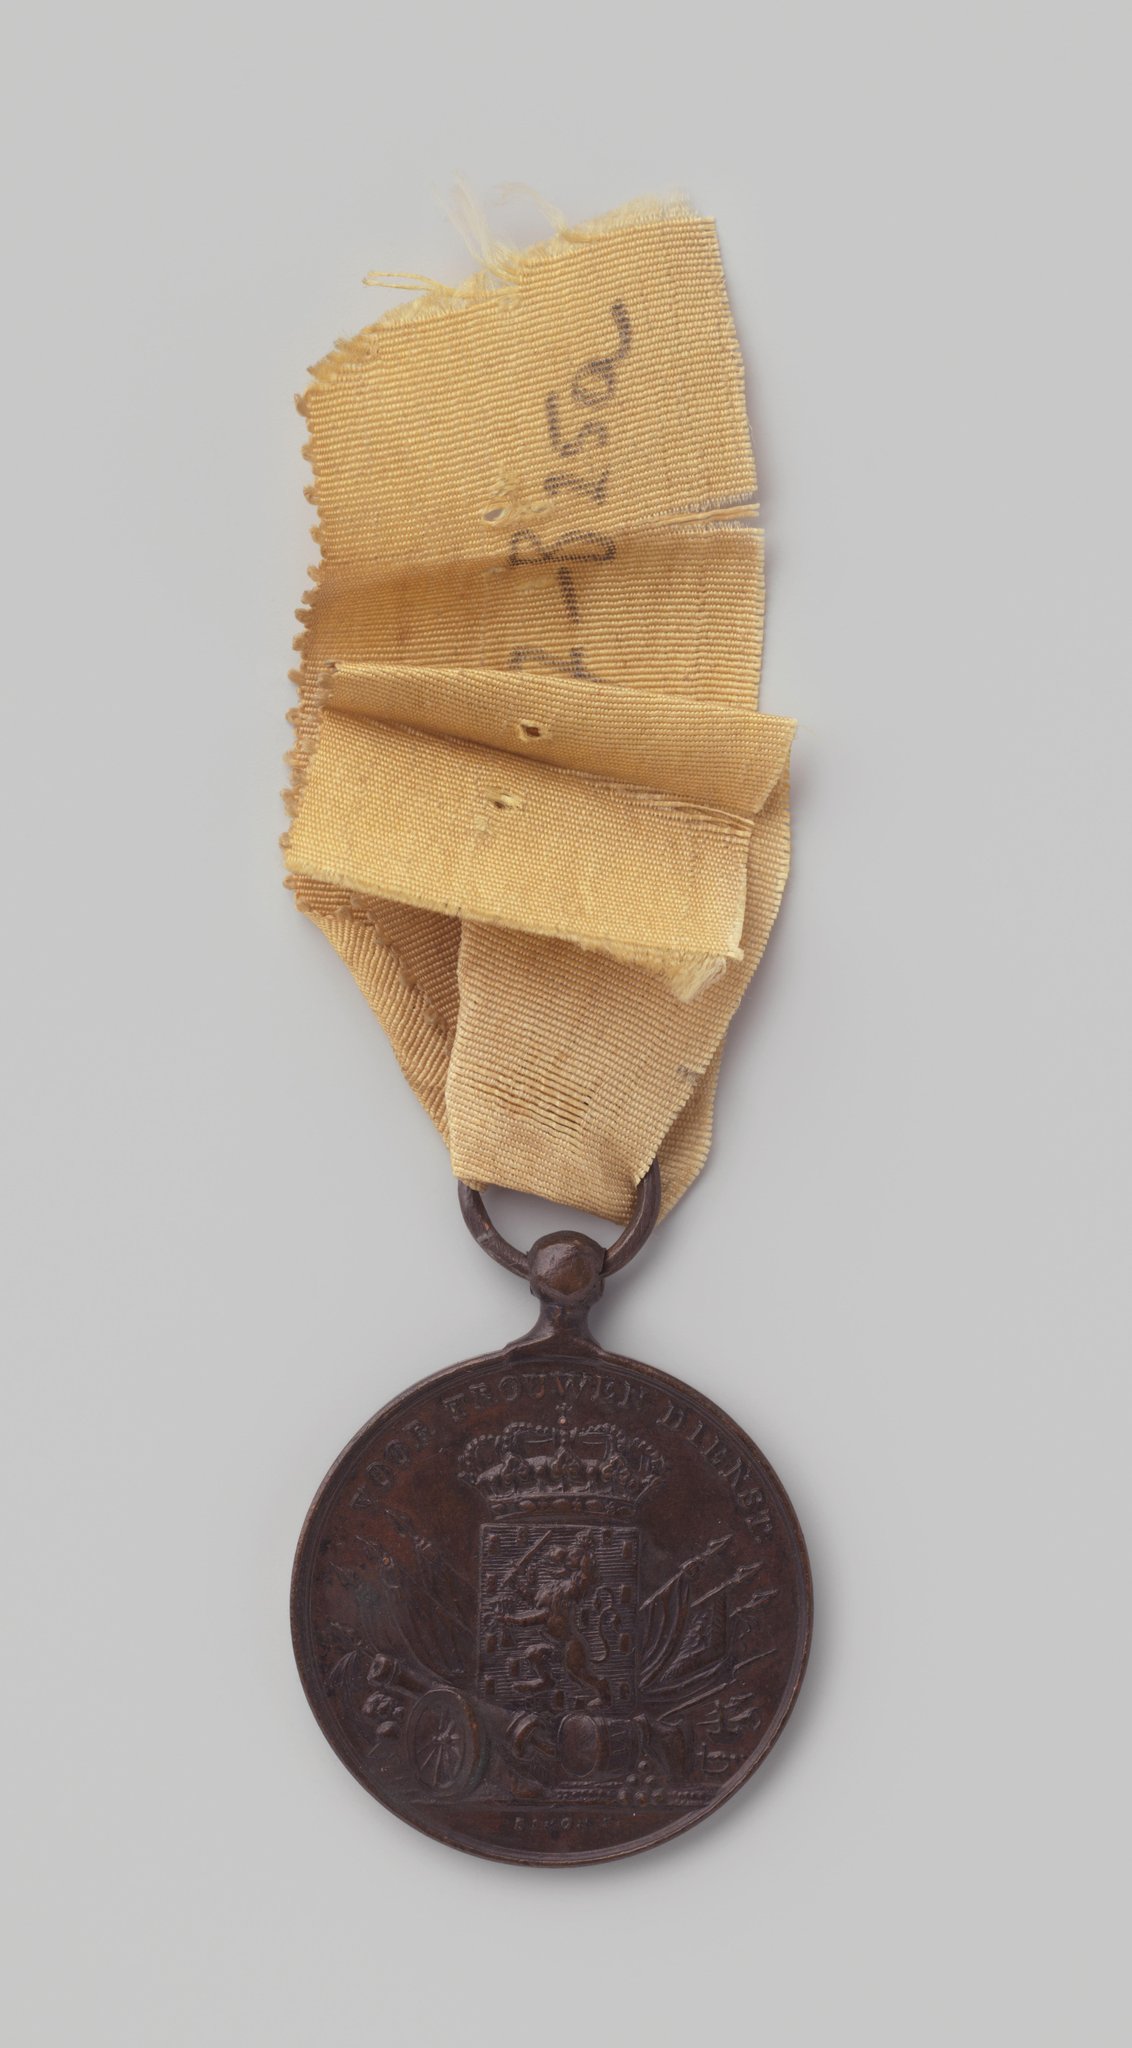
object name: onderscheidingsteken, onderscheiding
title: Medaille voor Trouwen Dienst met geel lint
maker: Anonymous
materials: bronze, textile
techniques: forging, striking, weave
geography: netherlands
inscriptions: : ‘VOOR TROUWEN DIENST’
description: Medaille voor trouwe dienst. Aan de voorzijde een kroon waar een met fluweel bedekte mantel uitvalt en de sierlijke letter W aan weerzijden bedekt. Aan de andere zijde het Nederlandse Wapen geflankeerd door vaandels, een kanon en trommels met de tekst VOOR TROUWEN DIENST. Bijbehorend een geel lint.